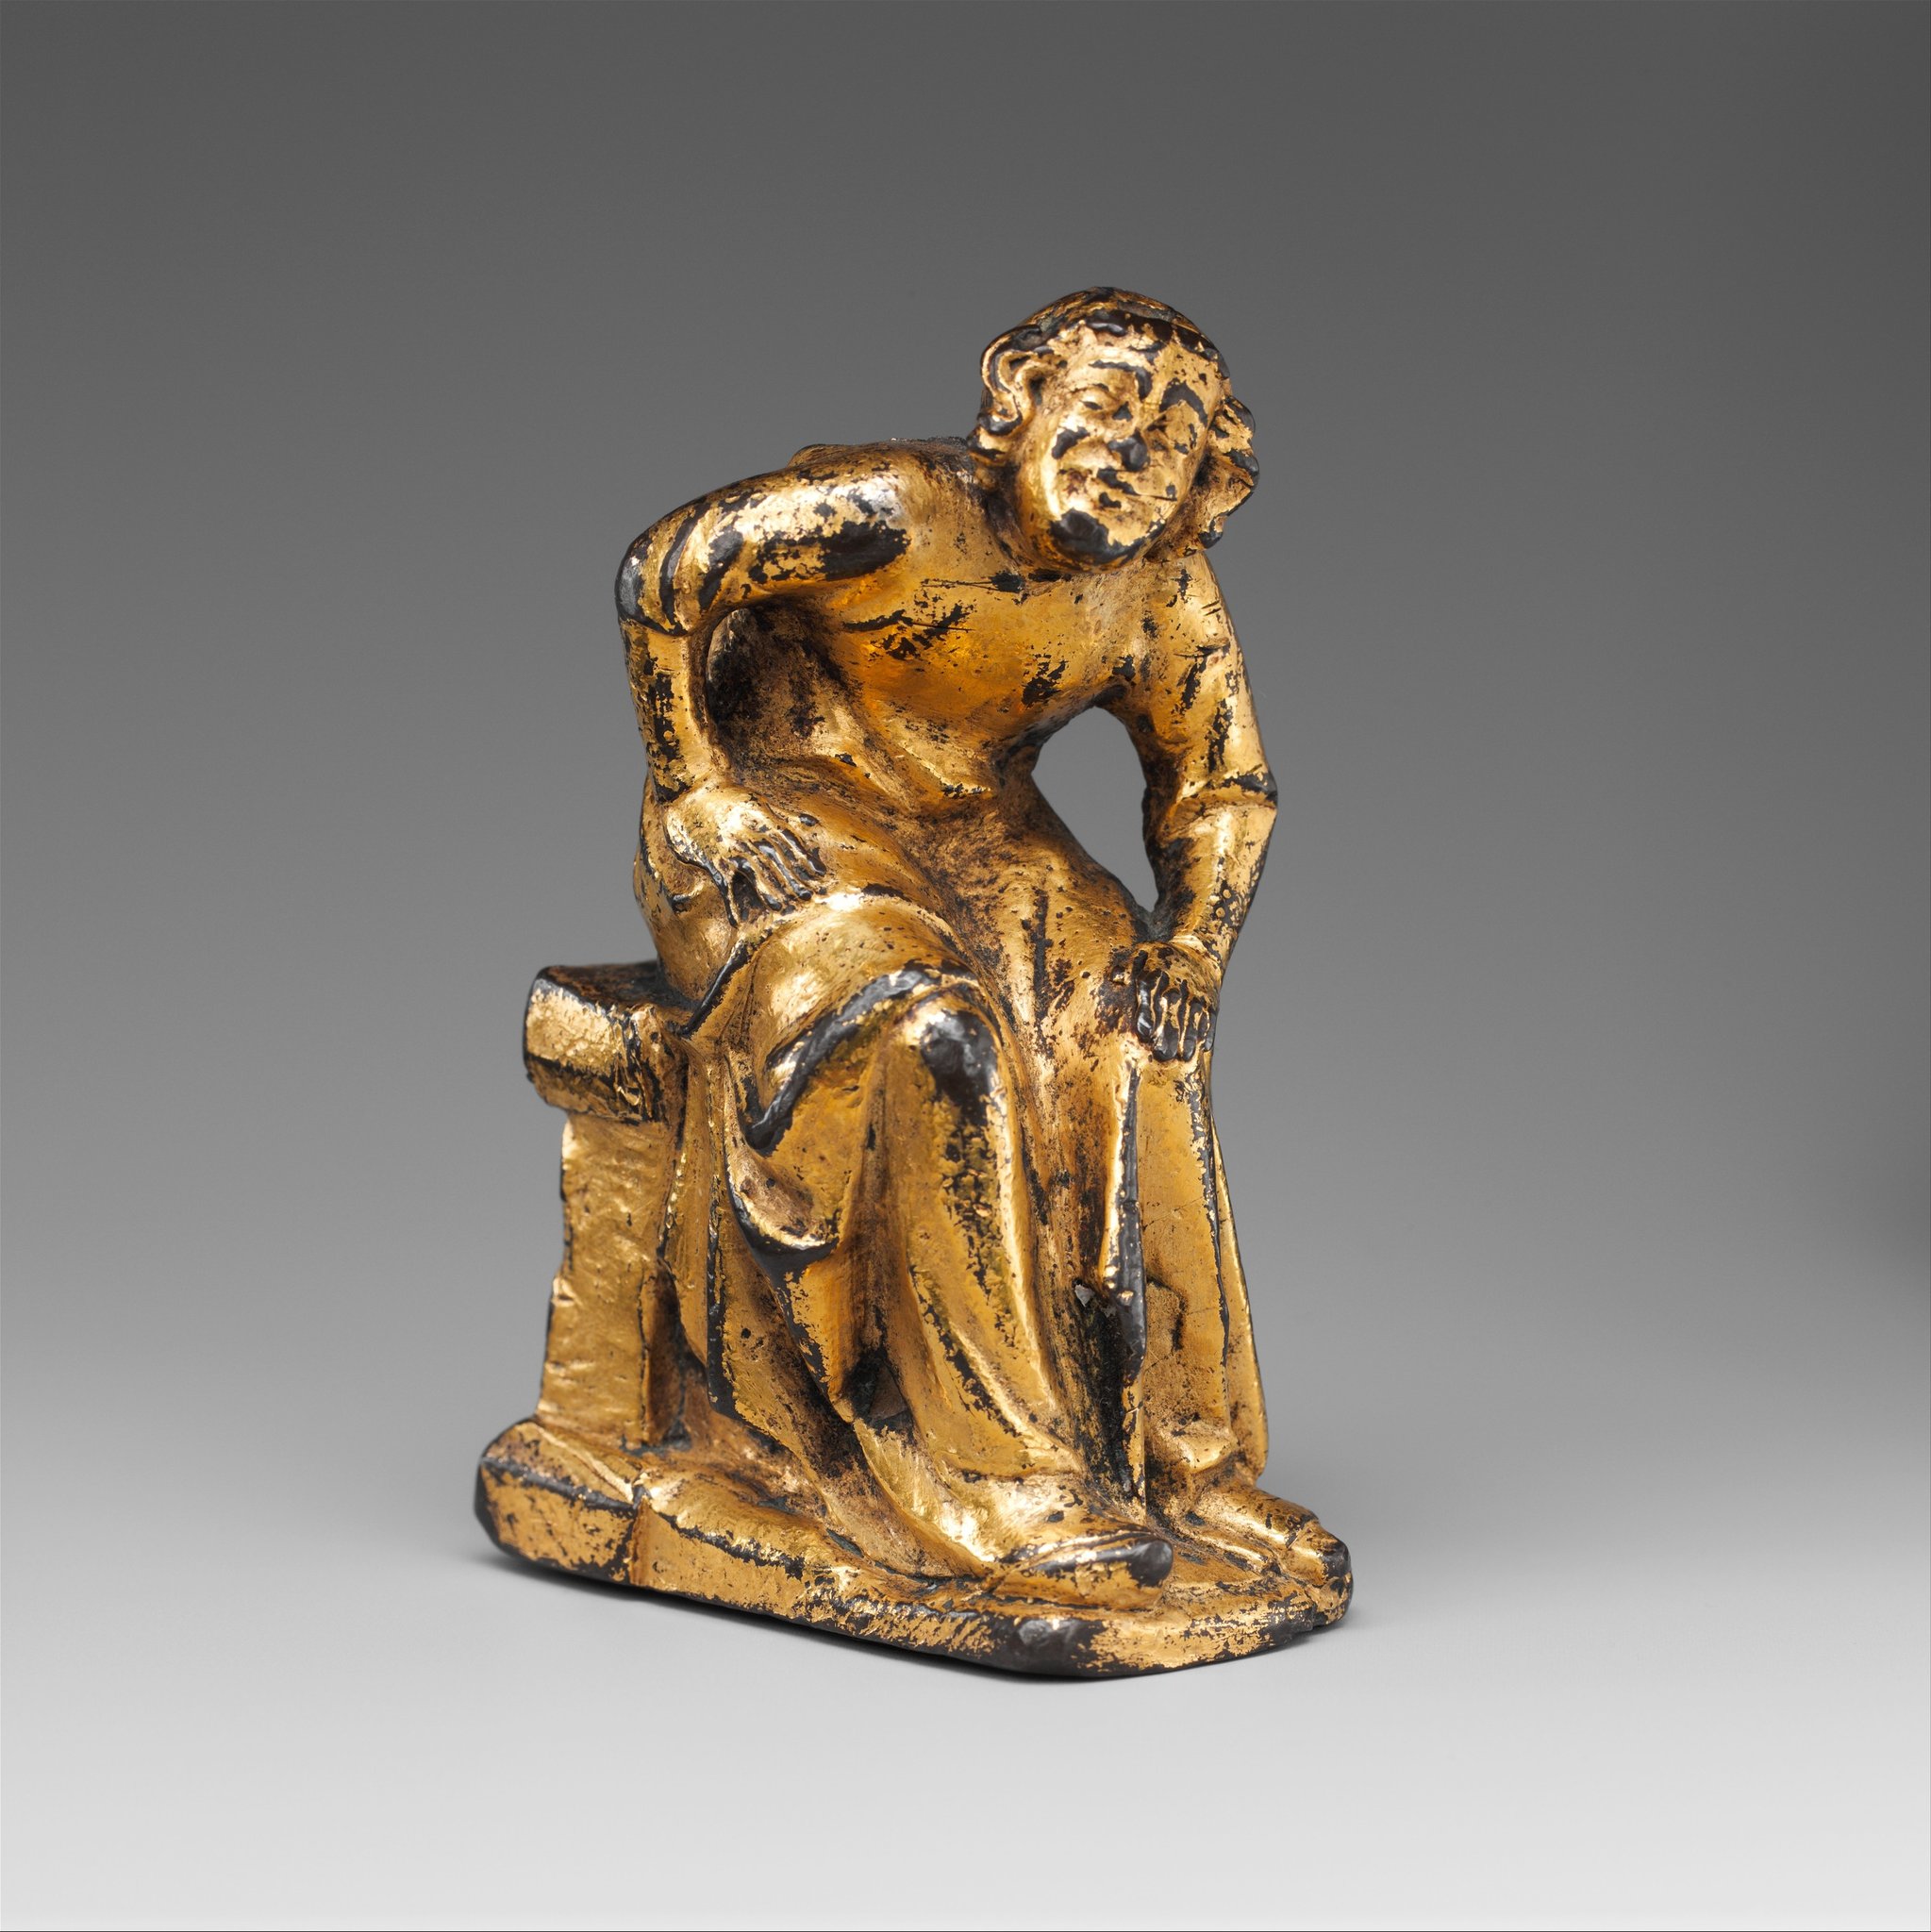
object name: statuette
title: Support Figure of a Seated Cleric or Friar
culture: french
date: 1280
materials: copper alloy, mercury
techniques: gilding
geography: france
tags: men